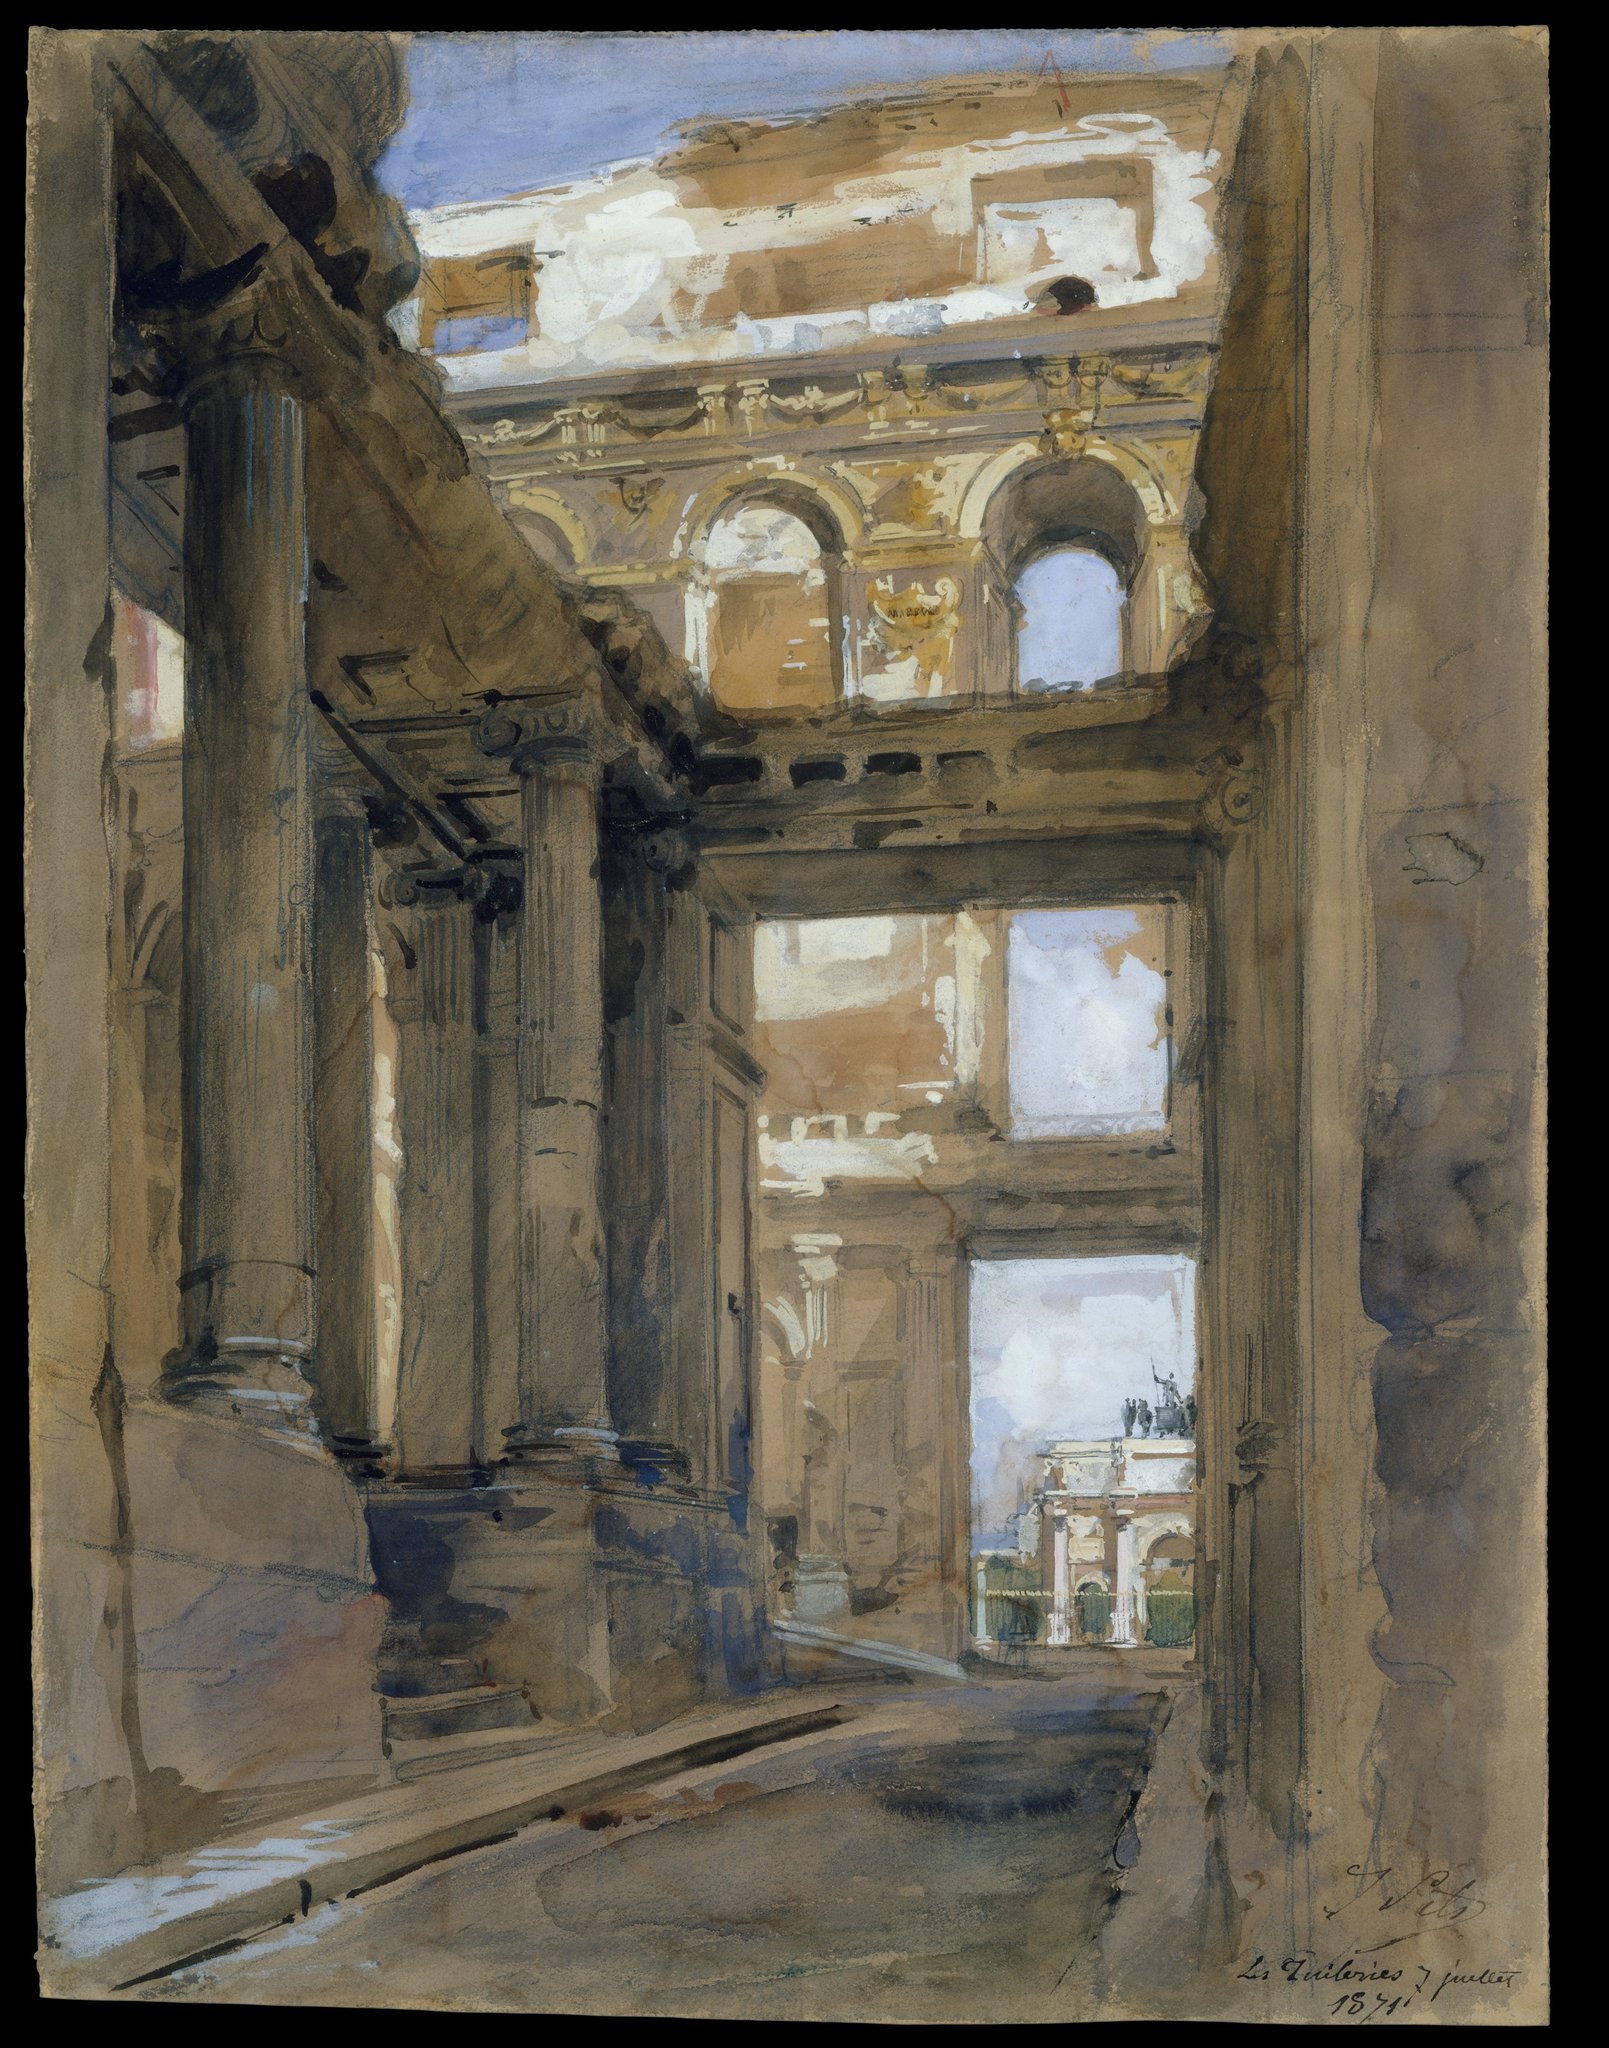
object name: drawing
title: Ruins of the Tuileries Palace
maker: isidore pils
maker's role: artist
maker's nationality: french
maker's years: 1813-1875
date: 1871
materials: gouache, graphite, paper, watercolor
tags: ruins